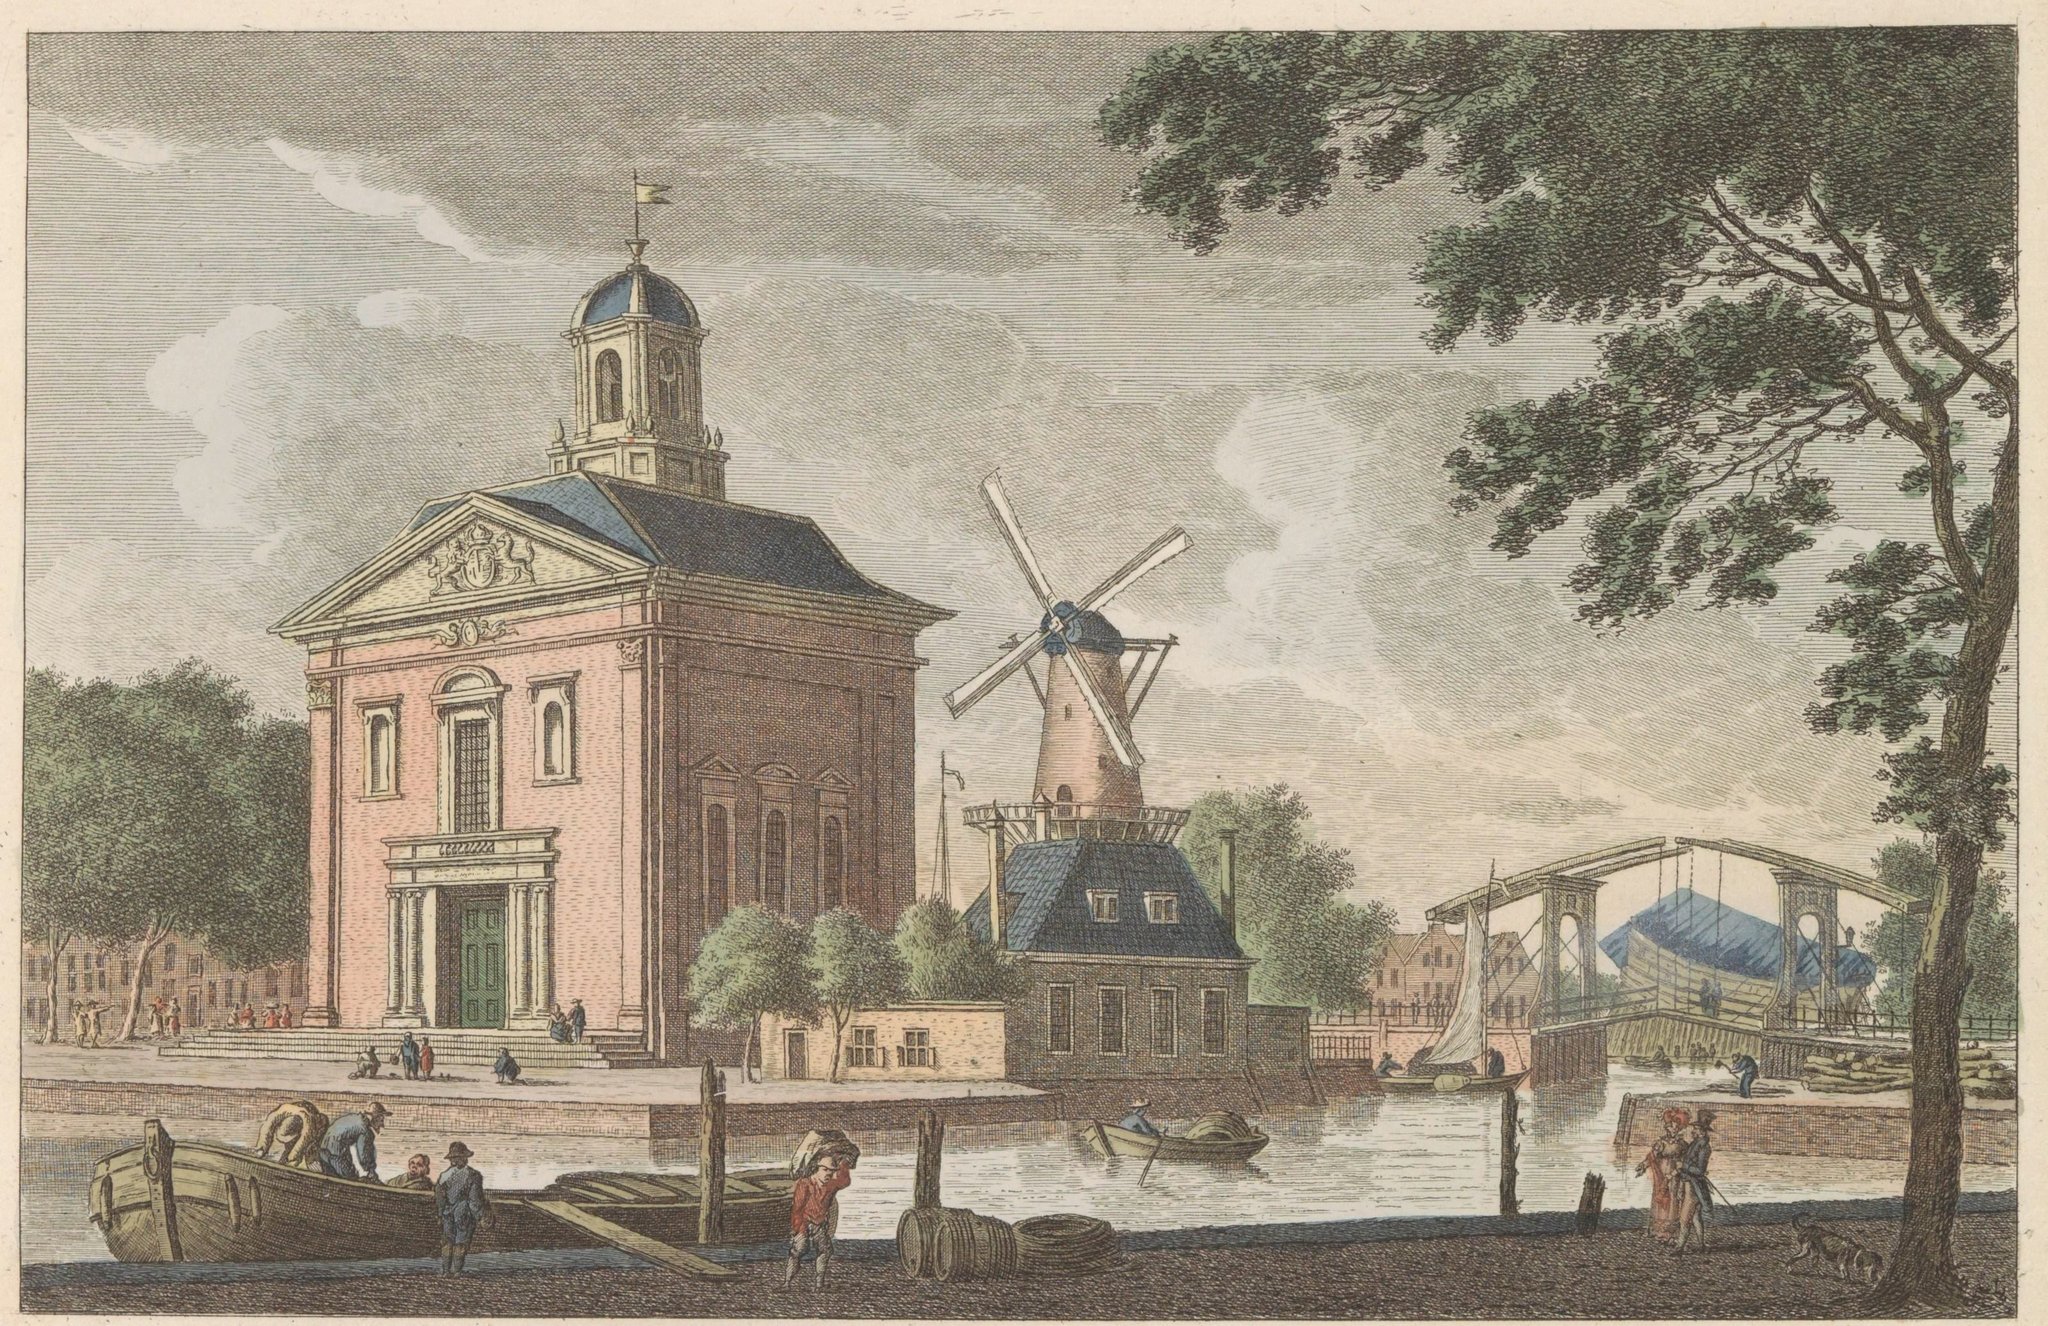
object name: print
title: Engelse kerk te Rotterdam, ca. 1790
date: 1786-1792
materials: paper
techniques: engraving, etching, hand coloring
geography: amsterdam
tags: church (exterior), rotterdam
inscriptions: inscription: ‘chez E: Maaskamp à Amsterdam’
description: Huidige staat van prent uitgegeven als onderdeel van een plaatwerk uit ca. 1824-1825 met 74 (ongenummerde) platen van de belangrijkste topografische gezichten en verschillende zeden en gewoonten in het Verenigd Koninkrijk der Nederlanden, getiteld 'Tableau des principales vues des palais et édifices : représentations et des coutumes et usages, dans les provinces septentrionales du Royaume des Pays-Bas'. Eerdere staat gebruikt in: Vaderlandsche gezichten, of afbeeldingen van den tegenwoordigen staat der Vereenigde Nederlanden (…). Amsterdam: Hendrik Gartman, Willem Vermandel en Jan Willem Smit, 1786-1792. Uitgegeven in afleveringen met ieder een eigen bifolium en inhoudsopgave. Alle prenten in deze publicatie zijn gegraveerd door Carel Frederik Bendorp (I) en, in de meeste gevallen, gebaseerd op tekeningen van Jan Bulthuis.